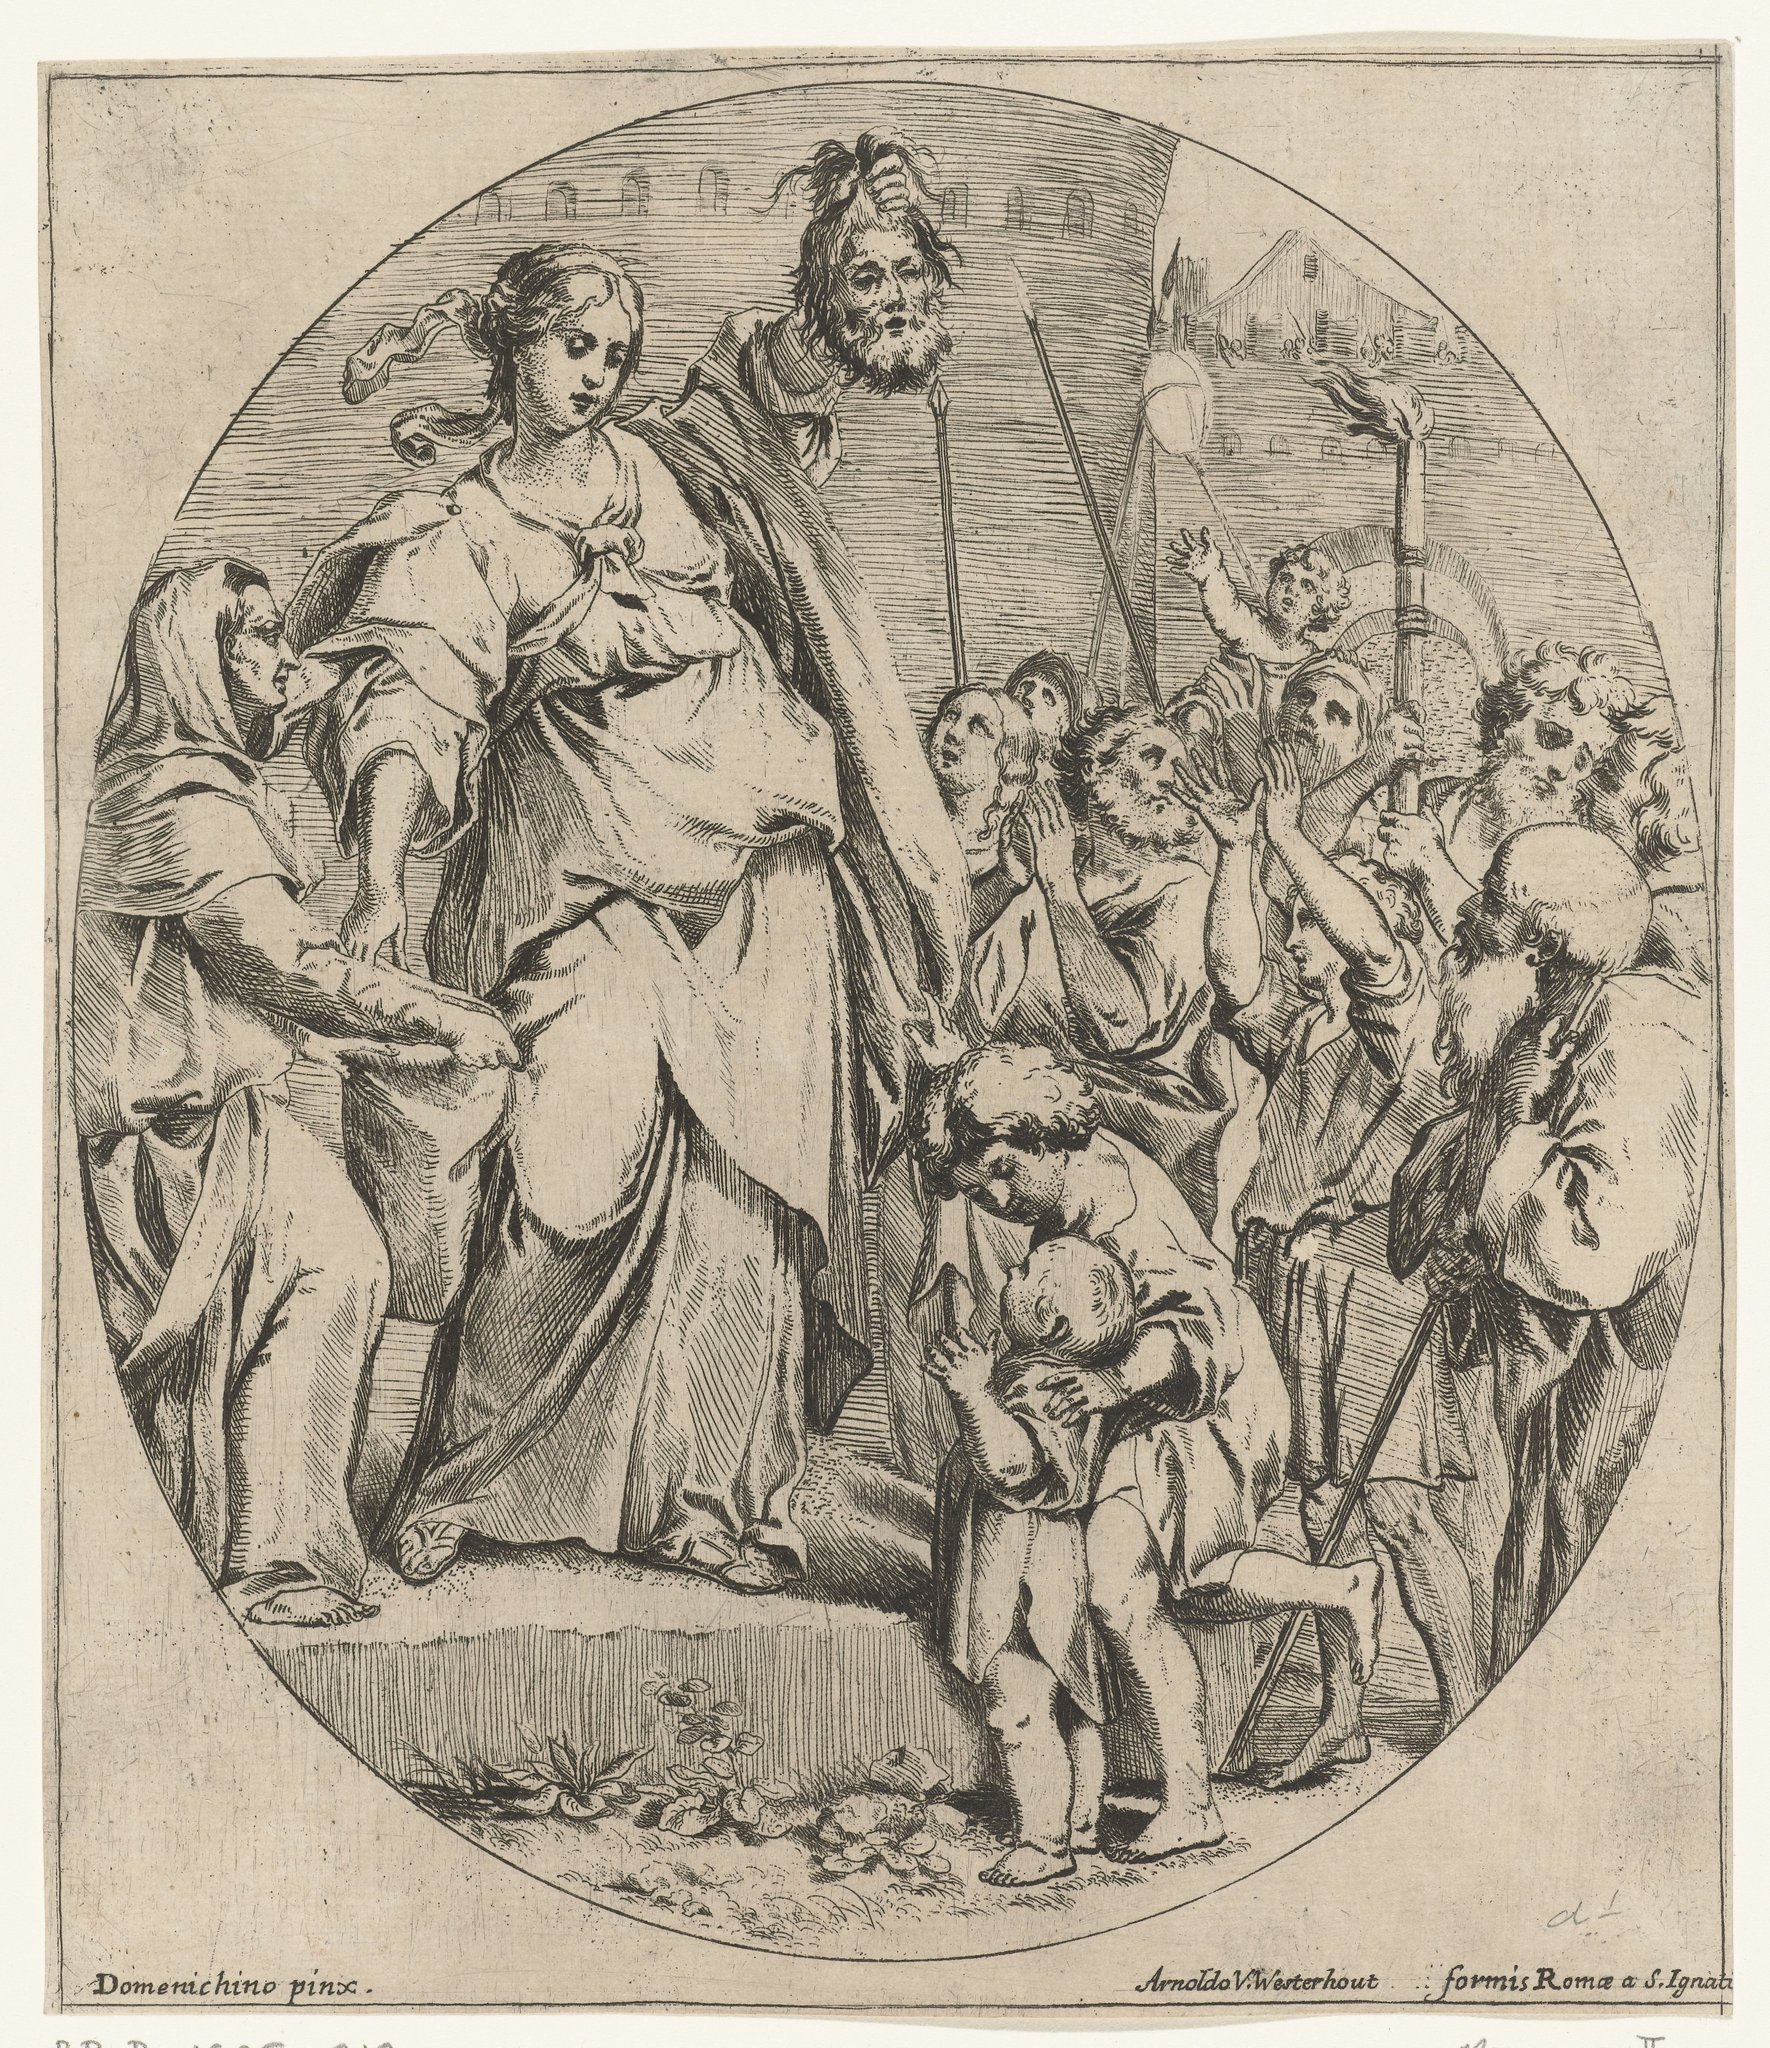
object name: print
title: Voorstellingen uit het Oude Testament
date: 1685-1725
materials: paper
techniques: etching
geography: rome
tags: judith shows holofernes' head to the people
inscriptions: collector's mark: Lugt 2228, collector's mark: Lugt 2760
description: Judit toont het hoofd van Holofernes aan het volk, naast haar staat haar dienstmaagd. Zij houdt de zak open waarin het hoofd opgeborgen was. Prent uit een serie van vier voorstellingen uit het Oude Testament naar fresco's van Domenichino.